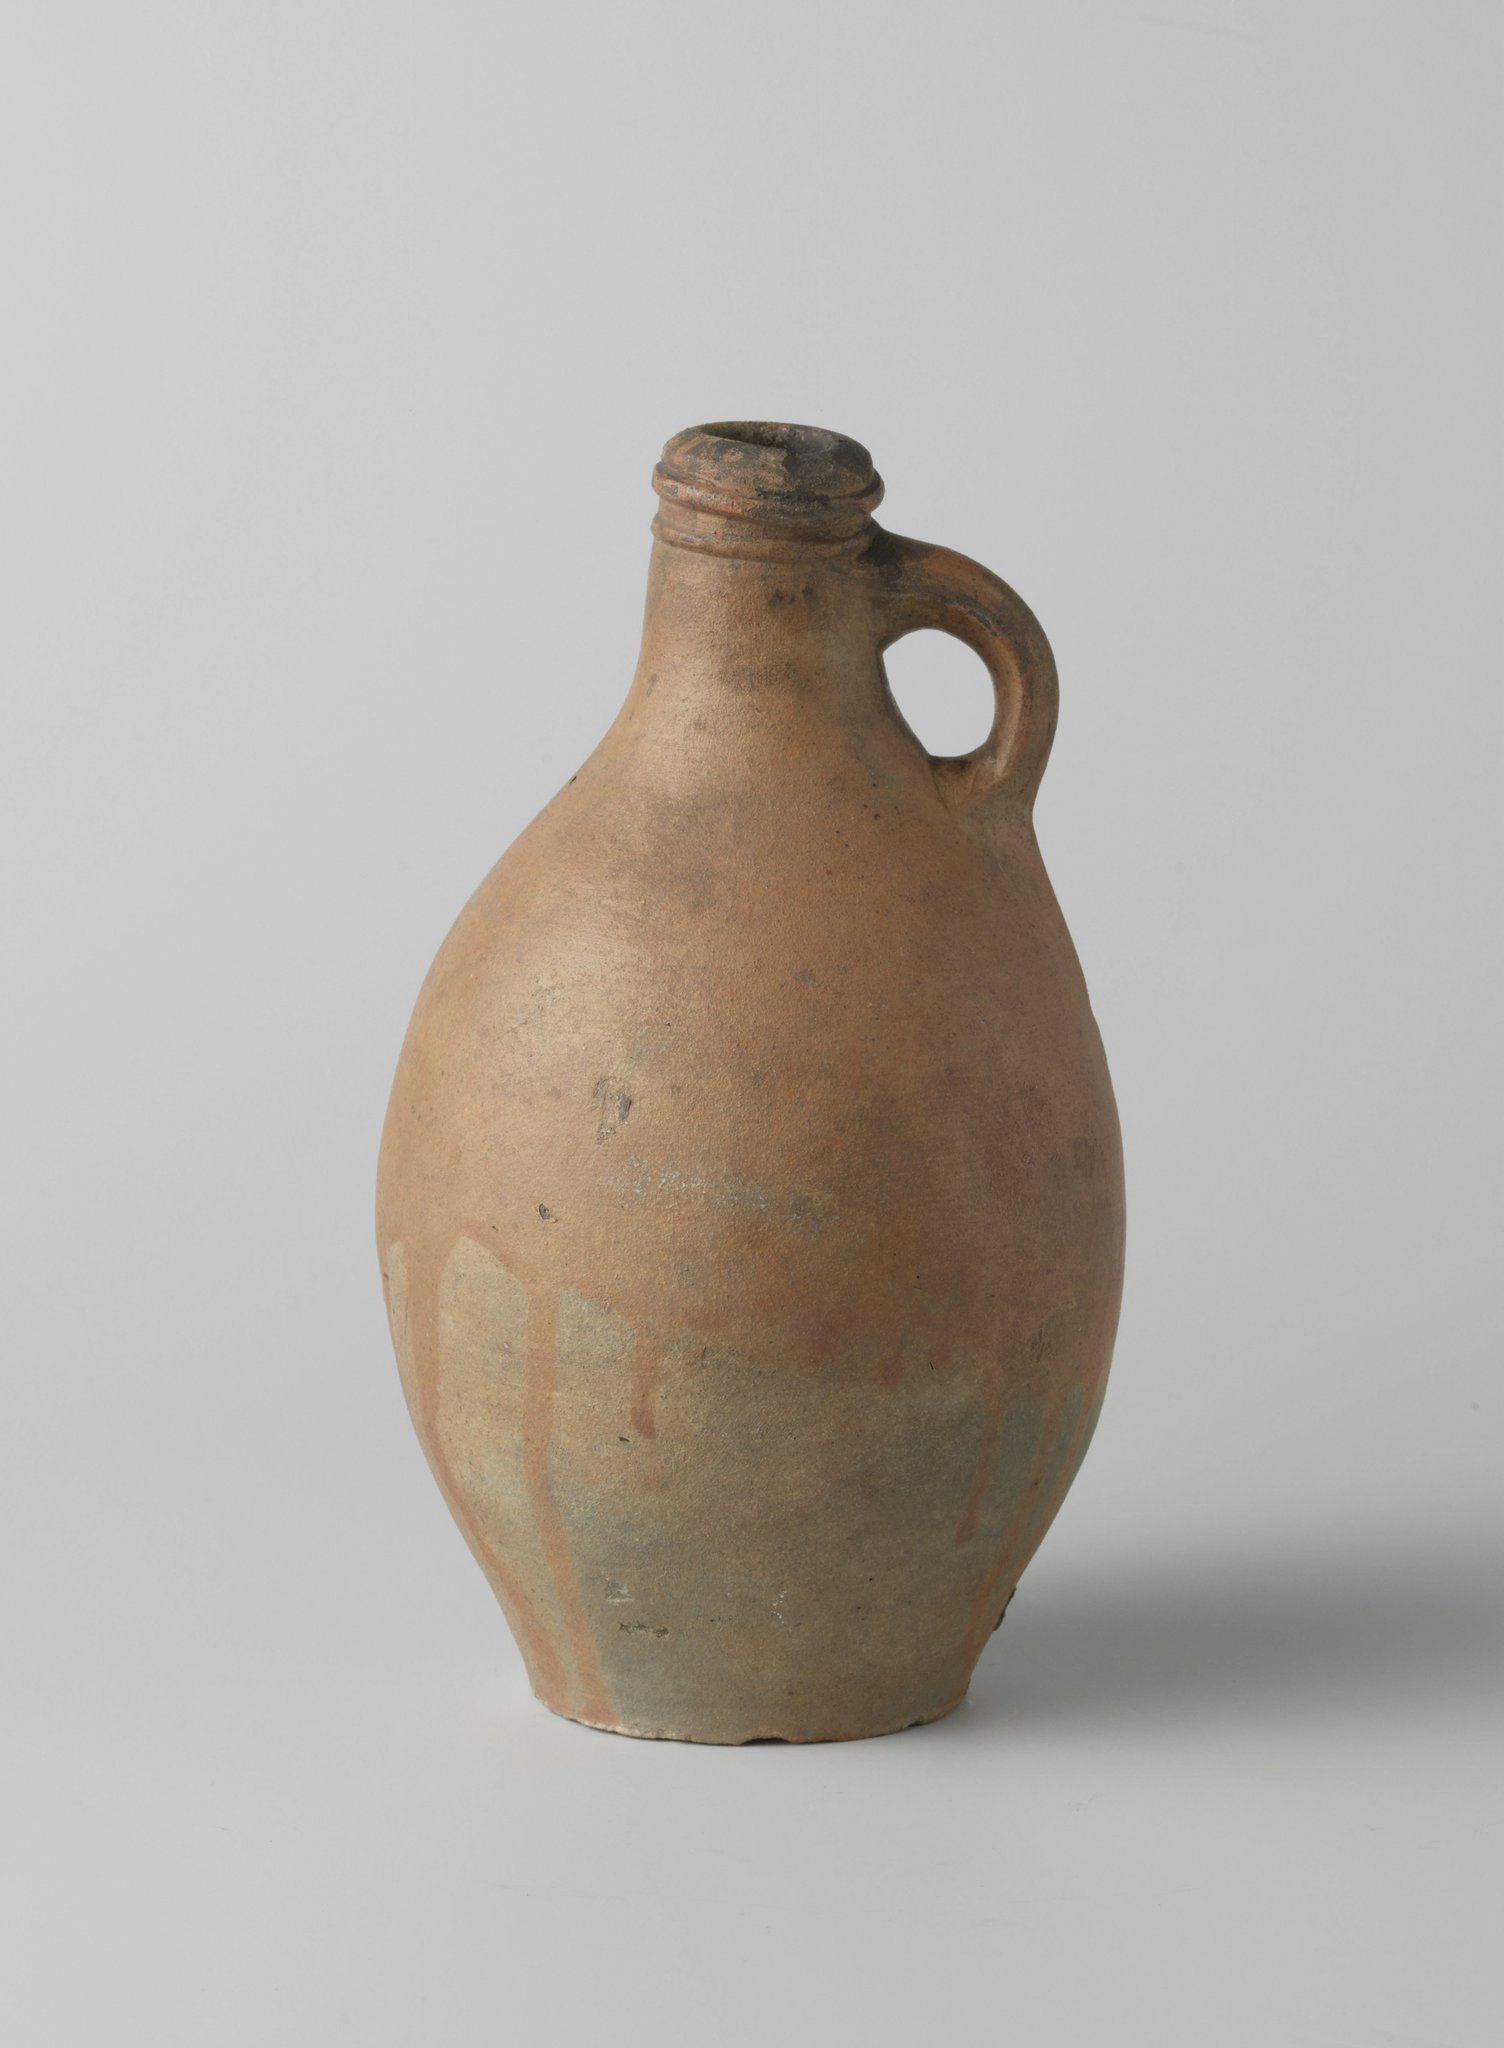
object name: jug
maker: Anonymous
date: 1700-1849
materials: engobe, glaze, stoneware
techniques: firing, forming, turning, vitrification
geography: frechen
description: Kruik van steengoed op standvlak met een eivormig lichaam en smalle nek. Het C-vormige oor is bevestigd aan de nek en de schouder. Profielen op de nek. Bedekt met een bruine engobe. Frechen[?].